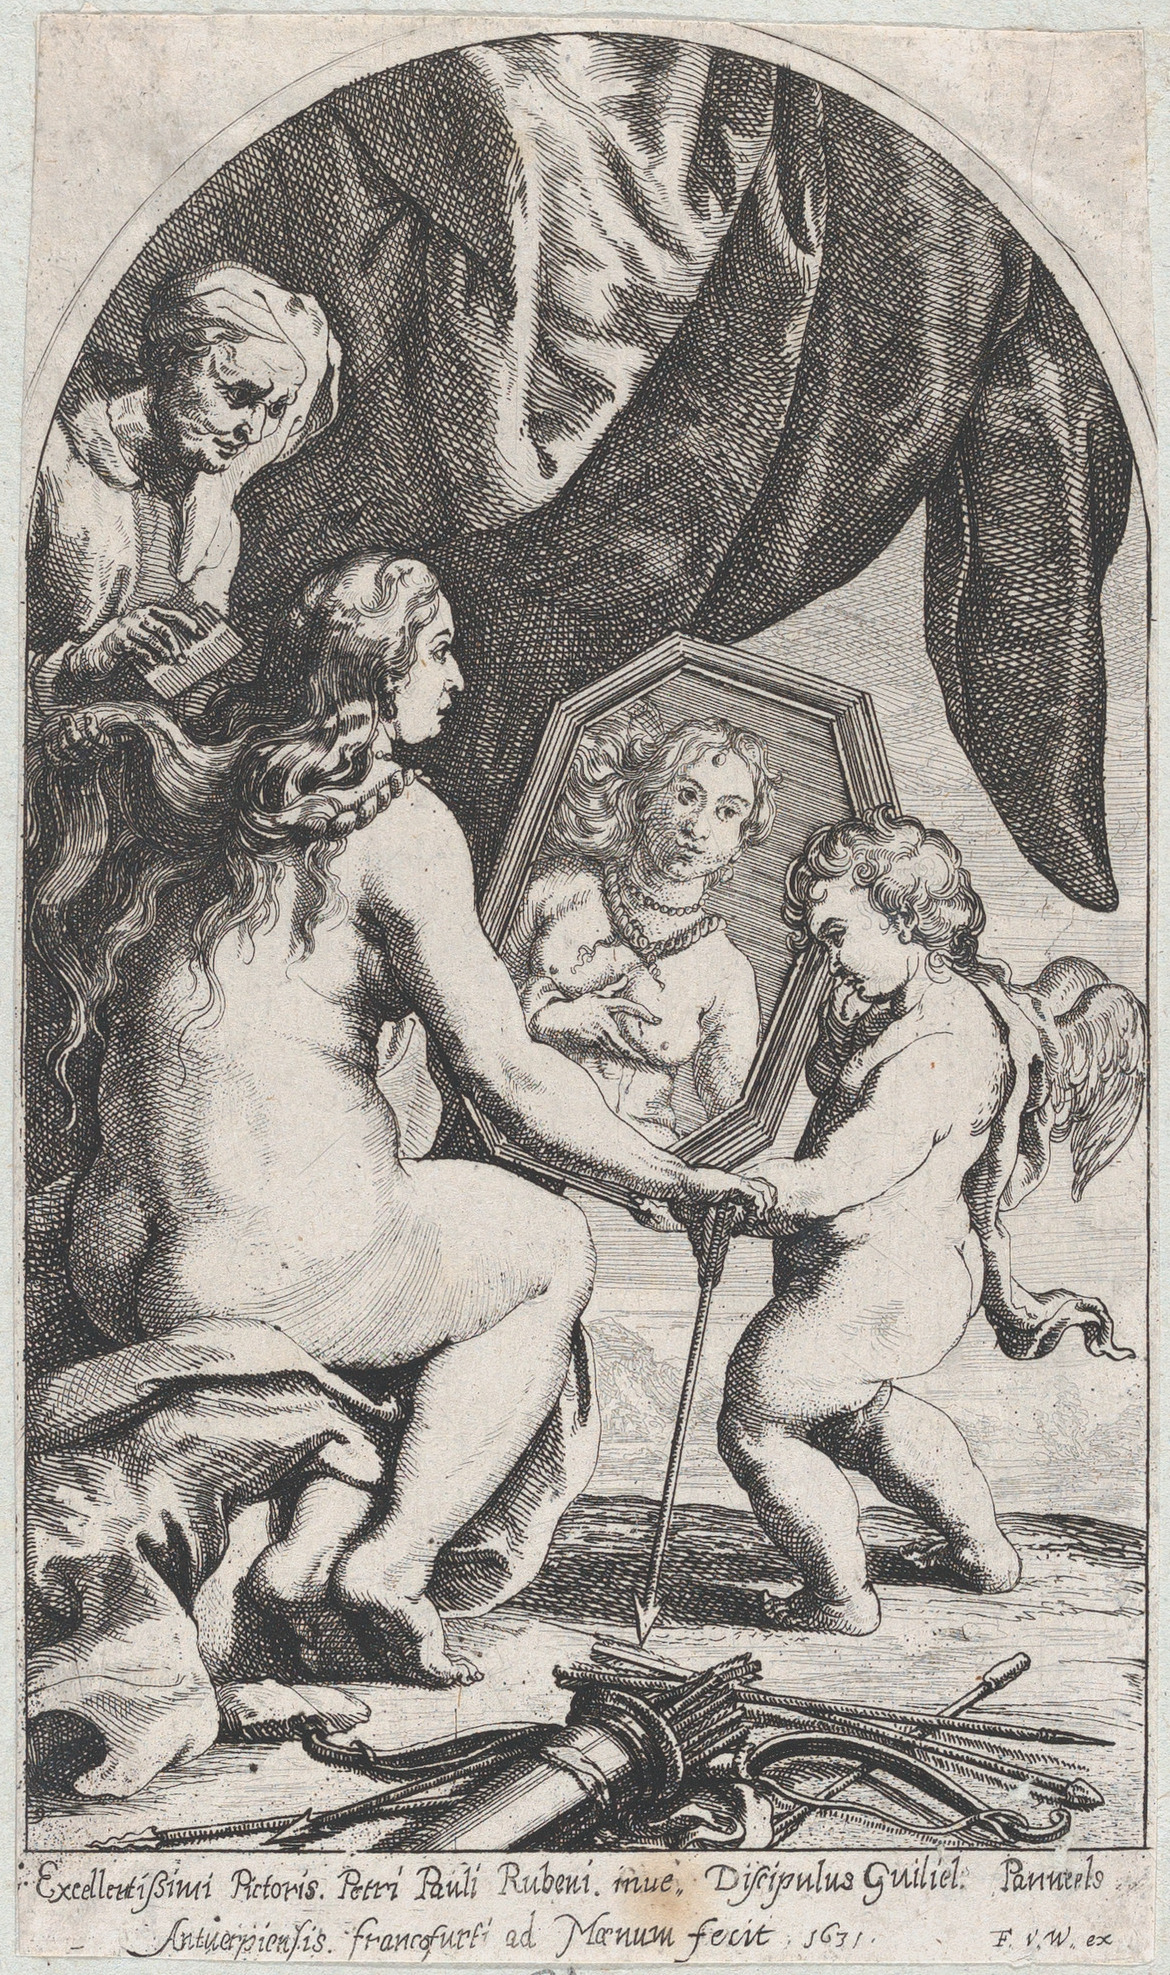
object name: print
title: Venus before a mirror held by Cupid while her hair is combed by an old woman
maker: willem panneels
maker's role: artist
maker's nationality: flemish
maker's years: 1600-1632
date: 1631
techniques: etching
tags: women,cupid,venus,mirrors